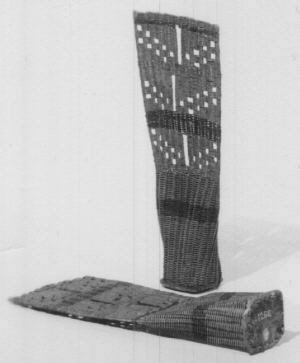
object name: pair of rattle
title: Pair of Rattles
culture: african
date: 1867-1900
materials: wood